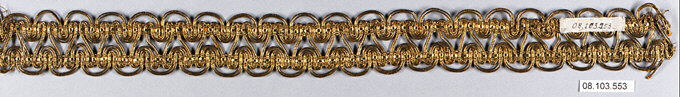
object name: galloon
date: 1701-1800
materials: metal thread